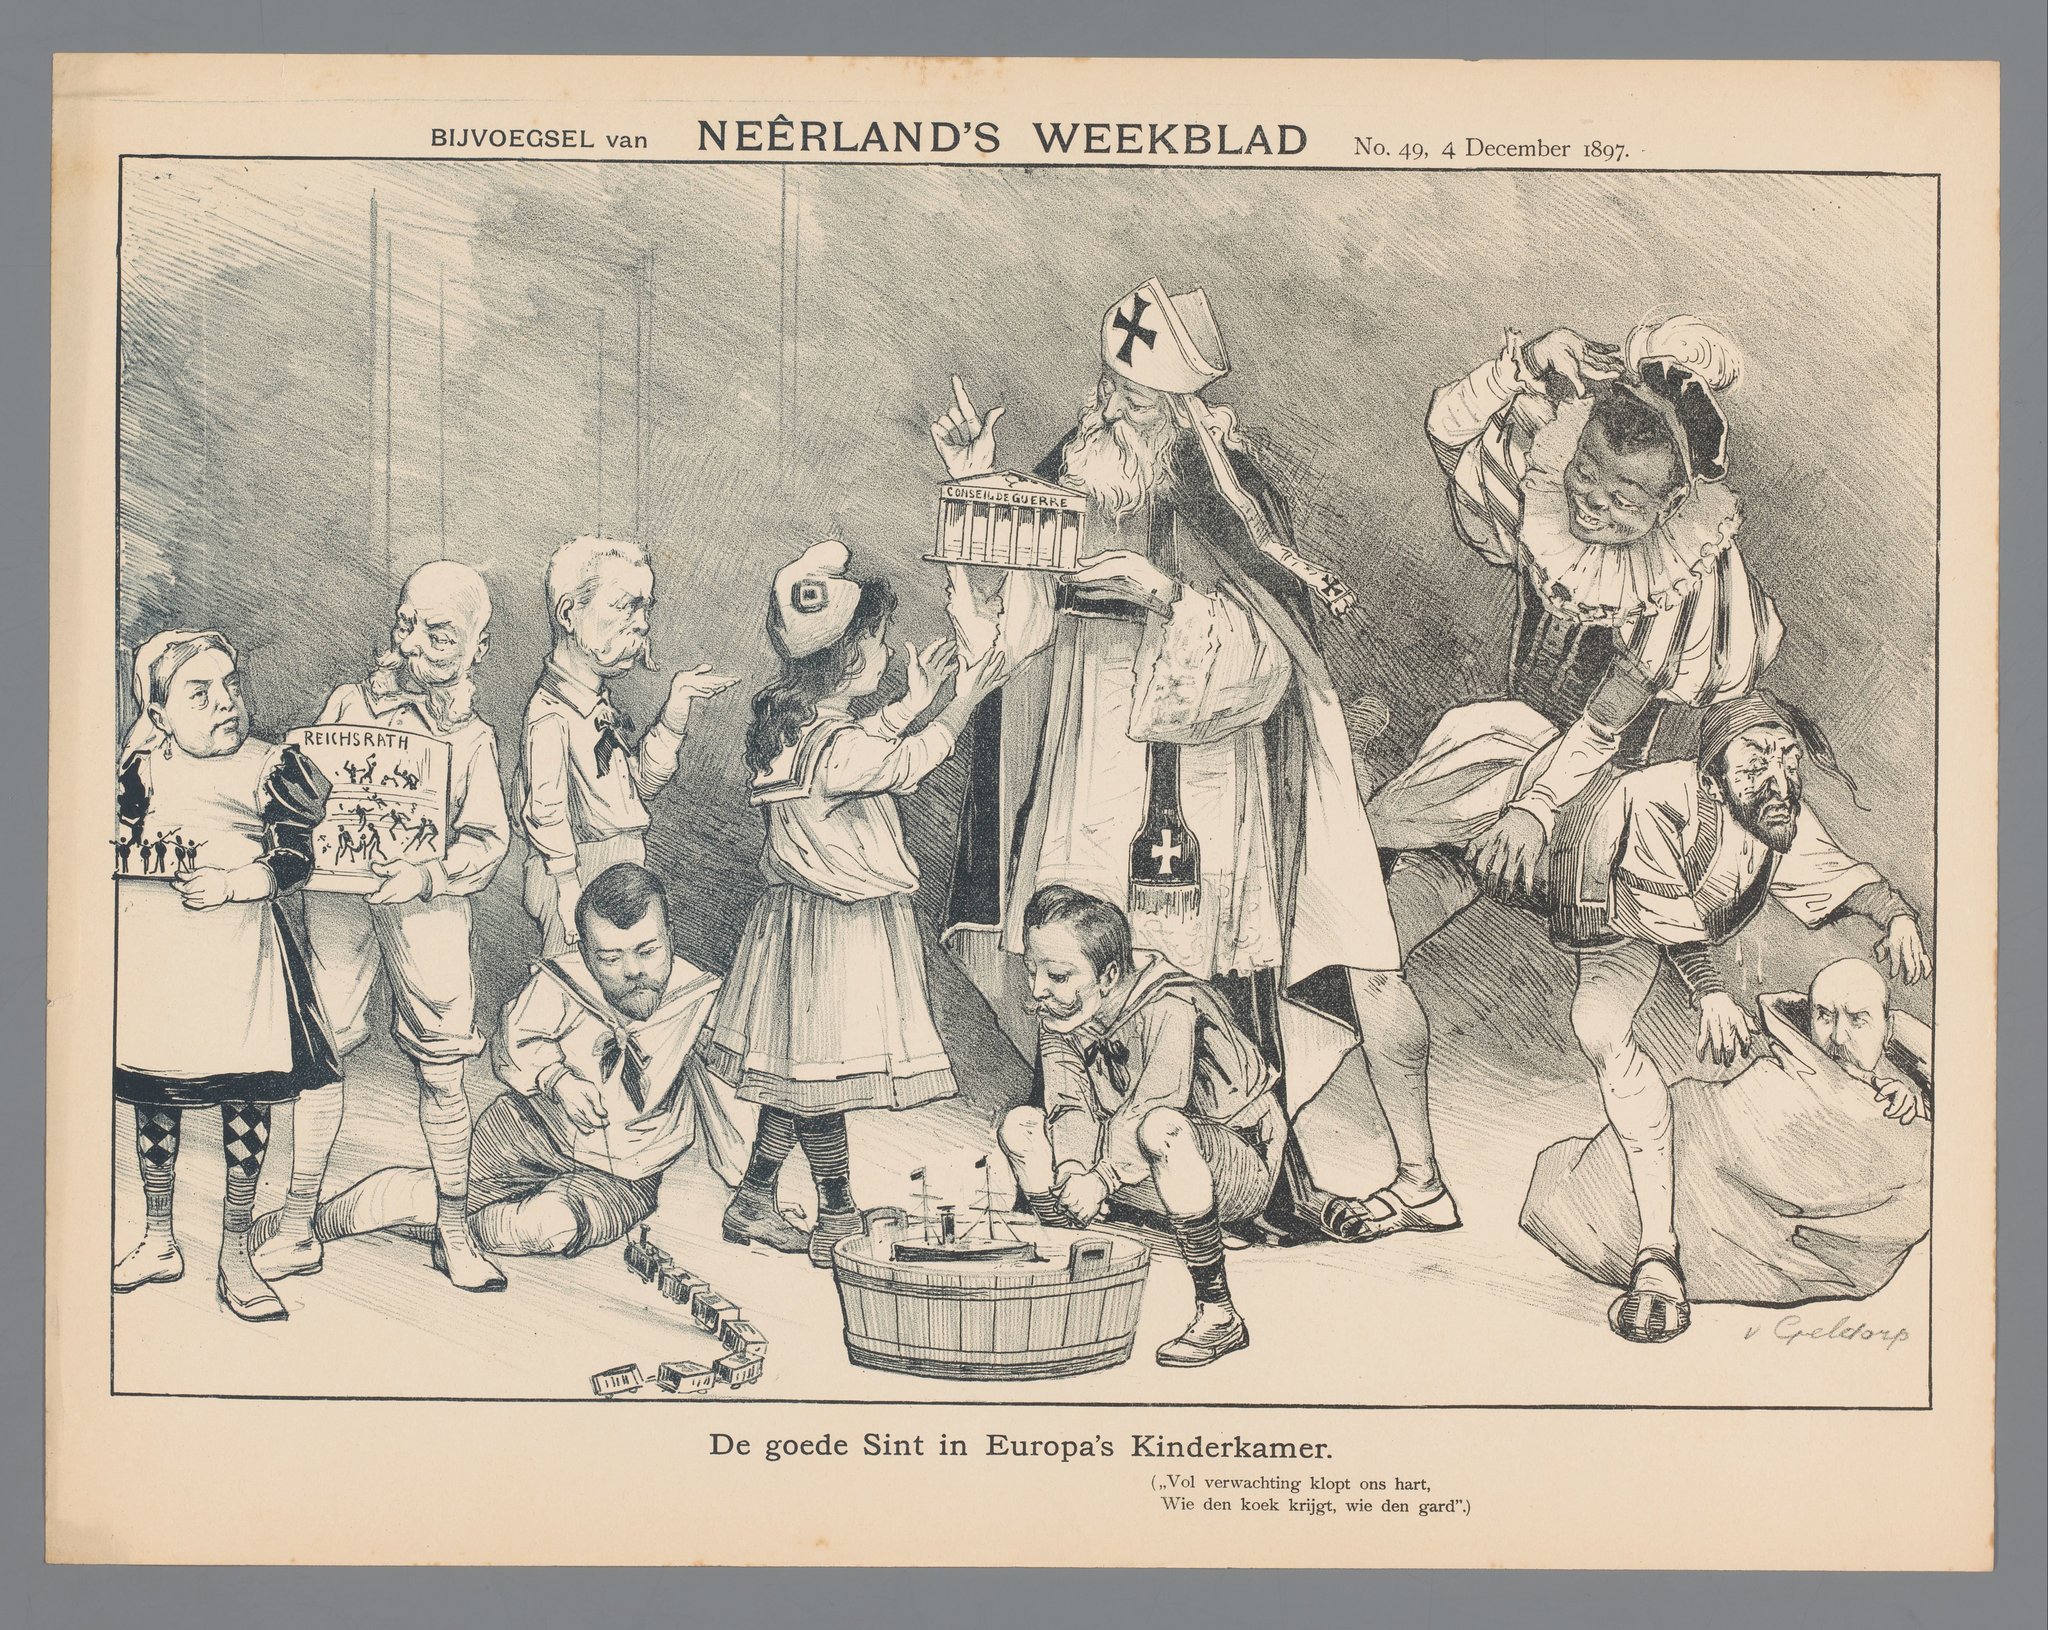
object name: cartoon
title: De goede Sint in Europa's Kinderkamer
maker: petrus van geldorp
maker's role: draughtsman, print maker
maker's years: 1872-1939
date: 1897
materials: paper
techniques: lithograph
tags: victoria (koningin van het verenigd koninkrijk en keizerin van india), copenhagen (city), wilhelm ii (keizer van duitsland), personifications of countries, nations, states, districts, etc., historical persons, festivities on st. nicholas (eve) (december 5), political caricatures and satires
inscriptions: date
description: Prent uit het bijvoegsel van: Neêrland’s Weekblad, nr. 49, 4 december 1897.